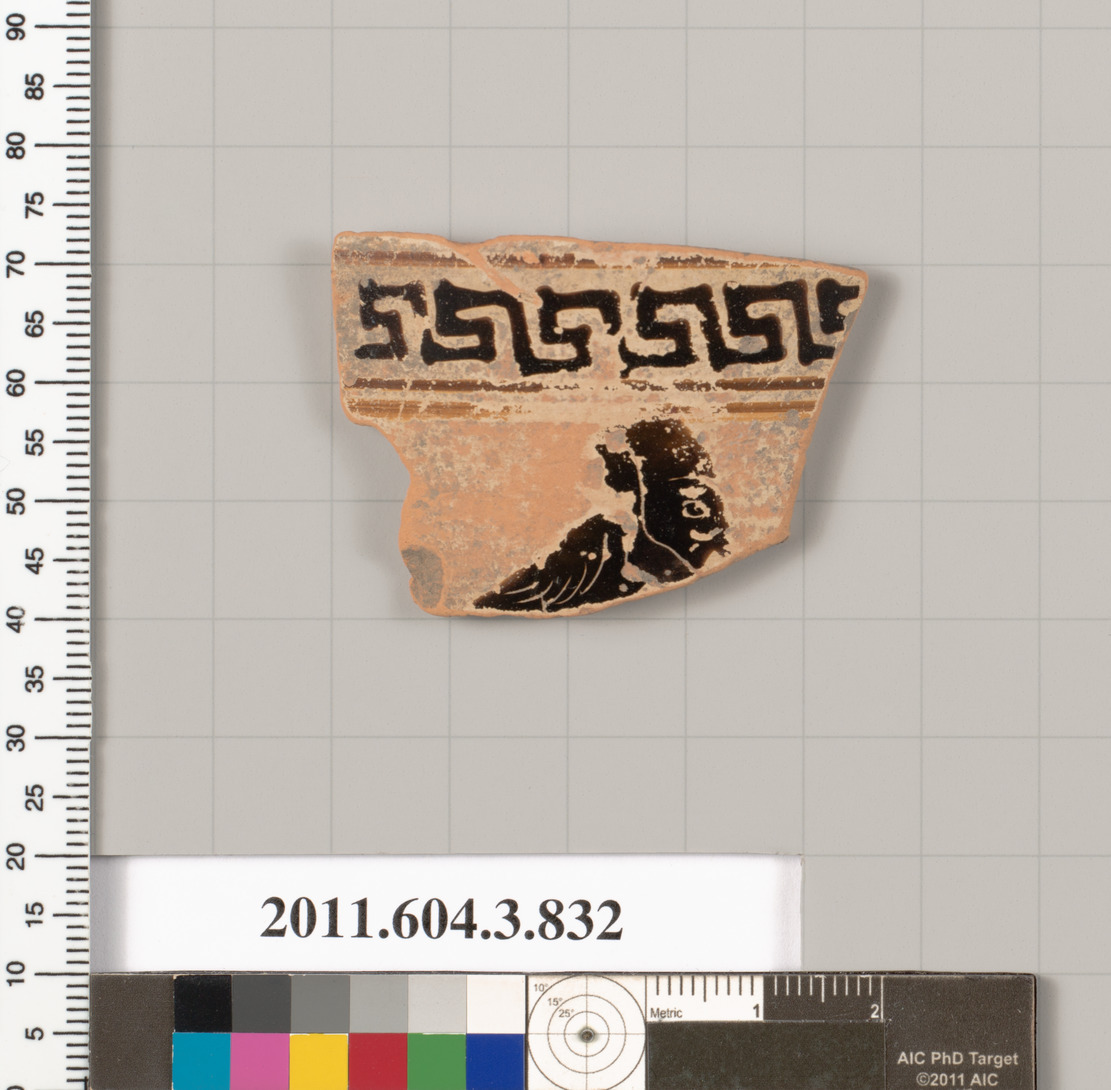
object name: lekythos fragment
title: Terracotta fragment of a lekythos (oil flask)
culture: greek, attic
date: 534-468 BCE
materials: terracotta